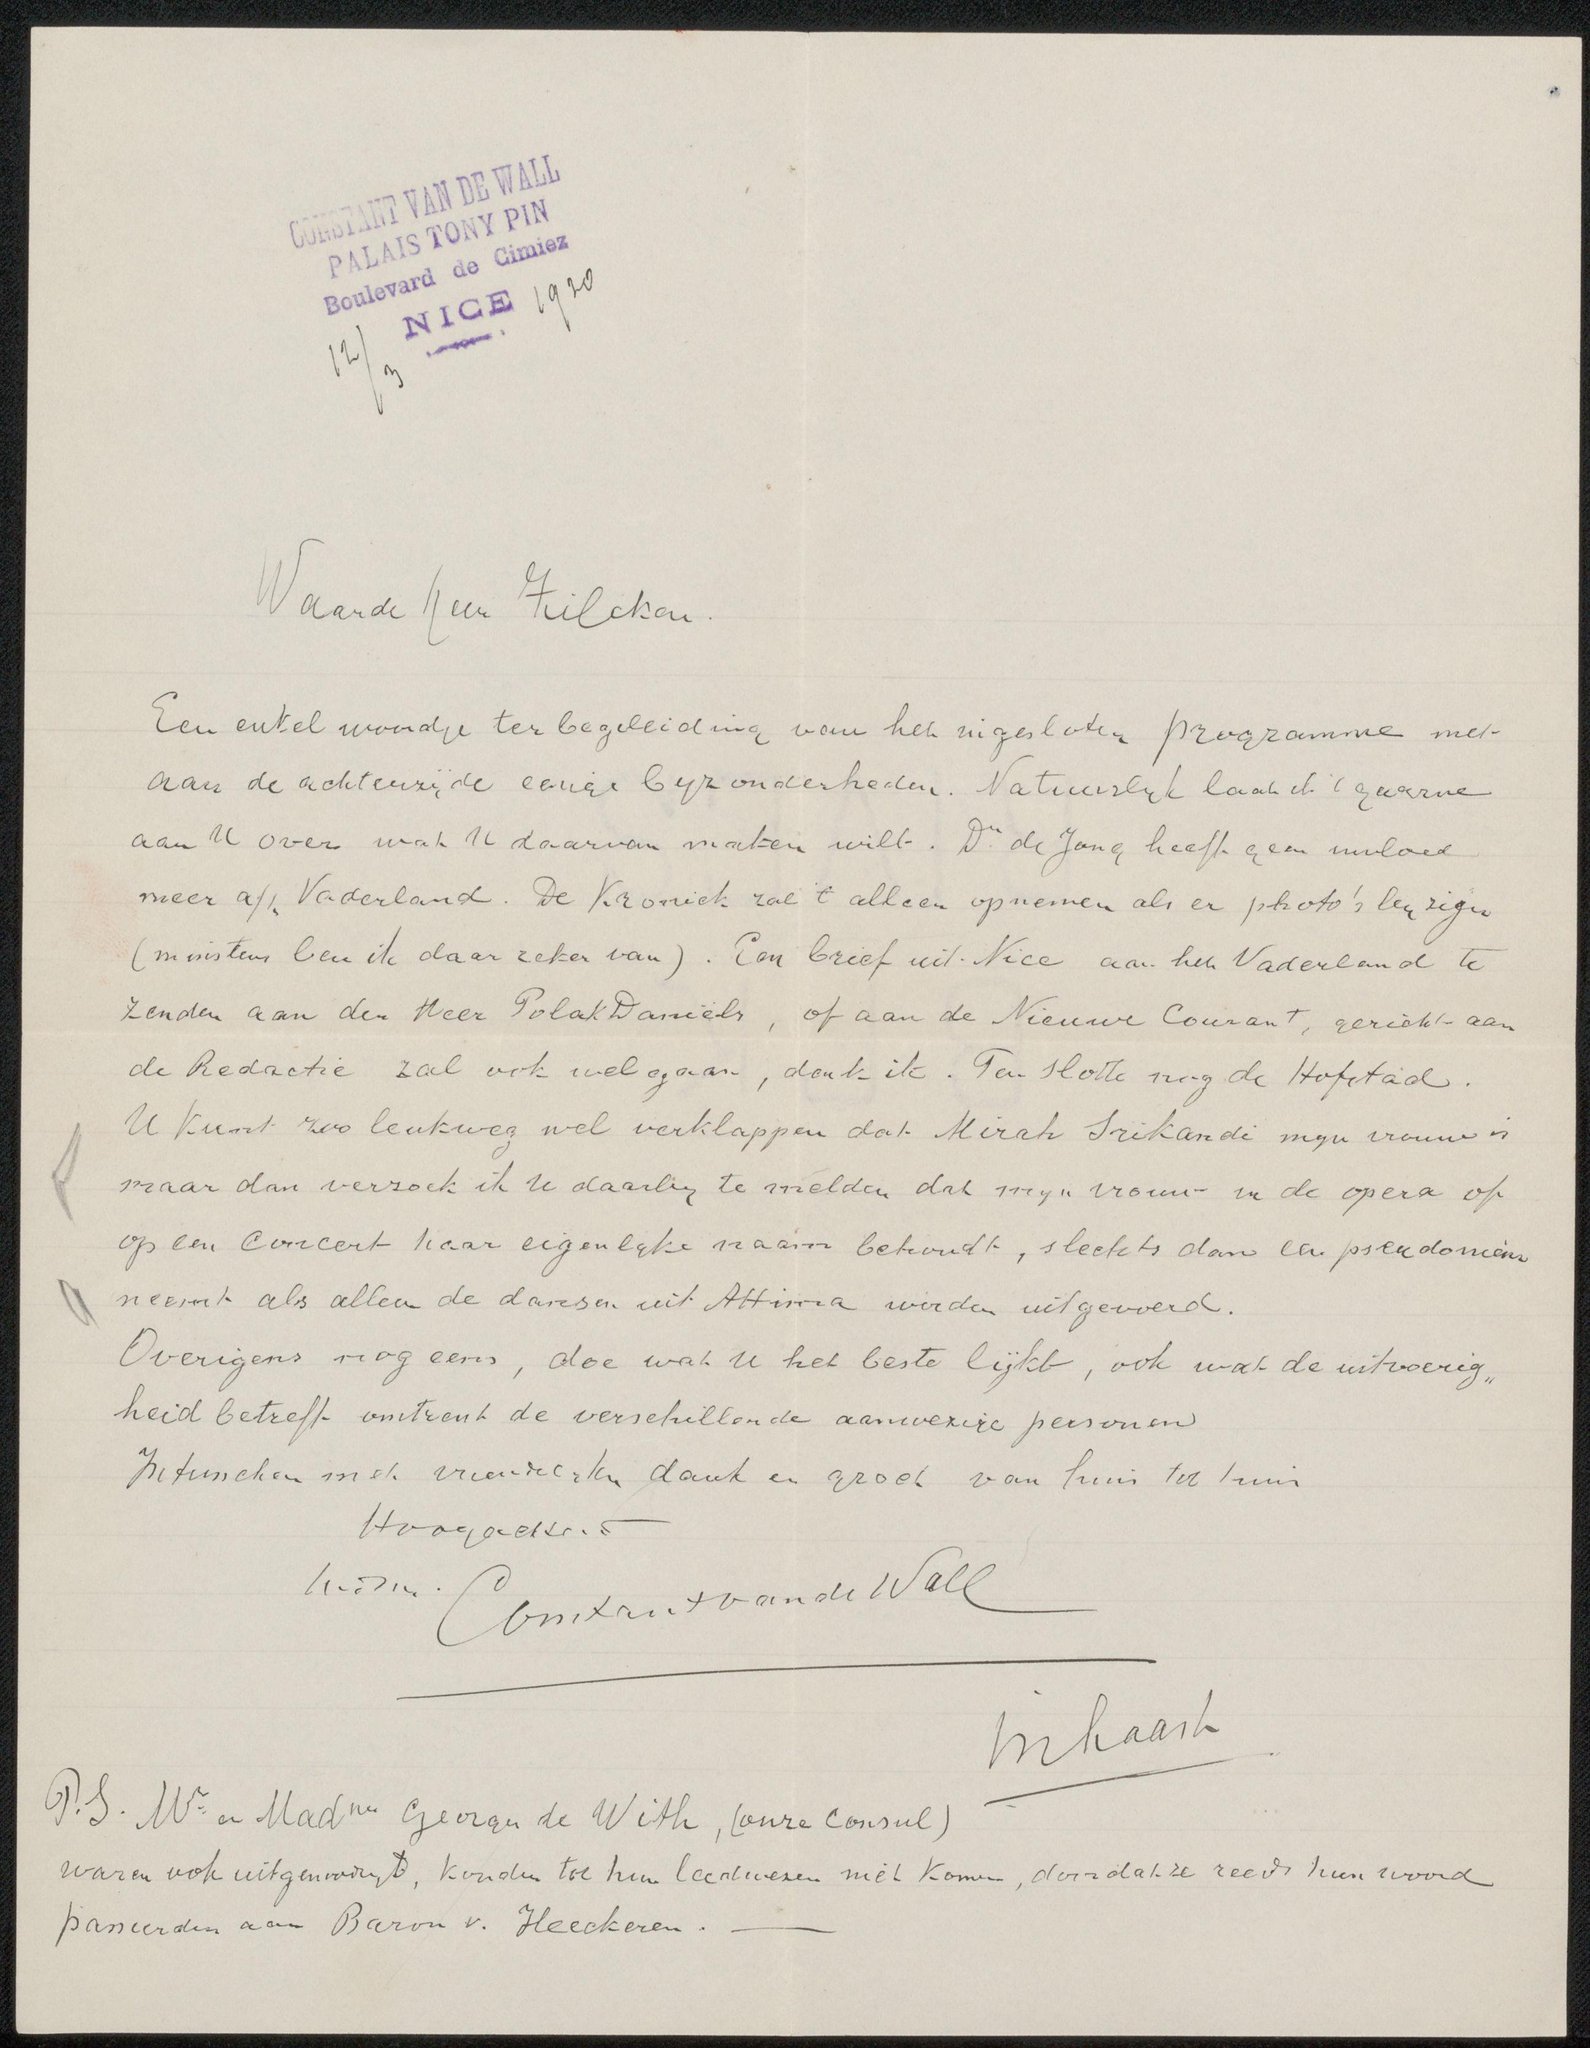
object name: letter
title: Brief aan Philip Zilcken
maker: johan constant arnold van de wall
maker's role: componist, dirigent, docent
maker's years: 1871-1945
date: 1920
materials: ink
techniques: pen, writing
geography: nice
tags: magazine, publisher, maria van de wall-van noppen, painter, draughtsman, philip zilcken, music, the arts of the stage: ballet, theatre, musical drama, motion picture, printed matter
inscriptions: address: ‘CONSTANT VAN DE WALL/ PALAIS TONY PIN/ Boulevard de Cimiez/ NICE’, collector's mark: ‘RPK’